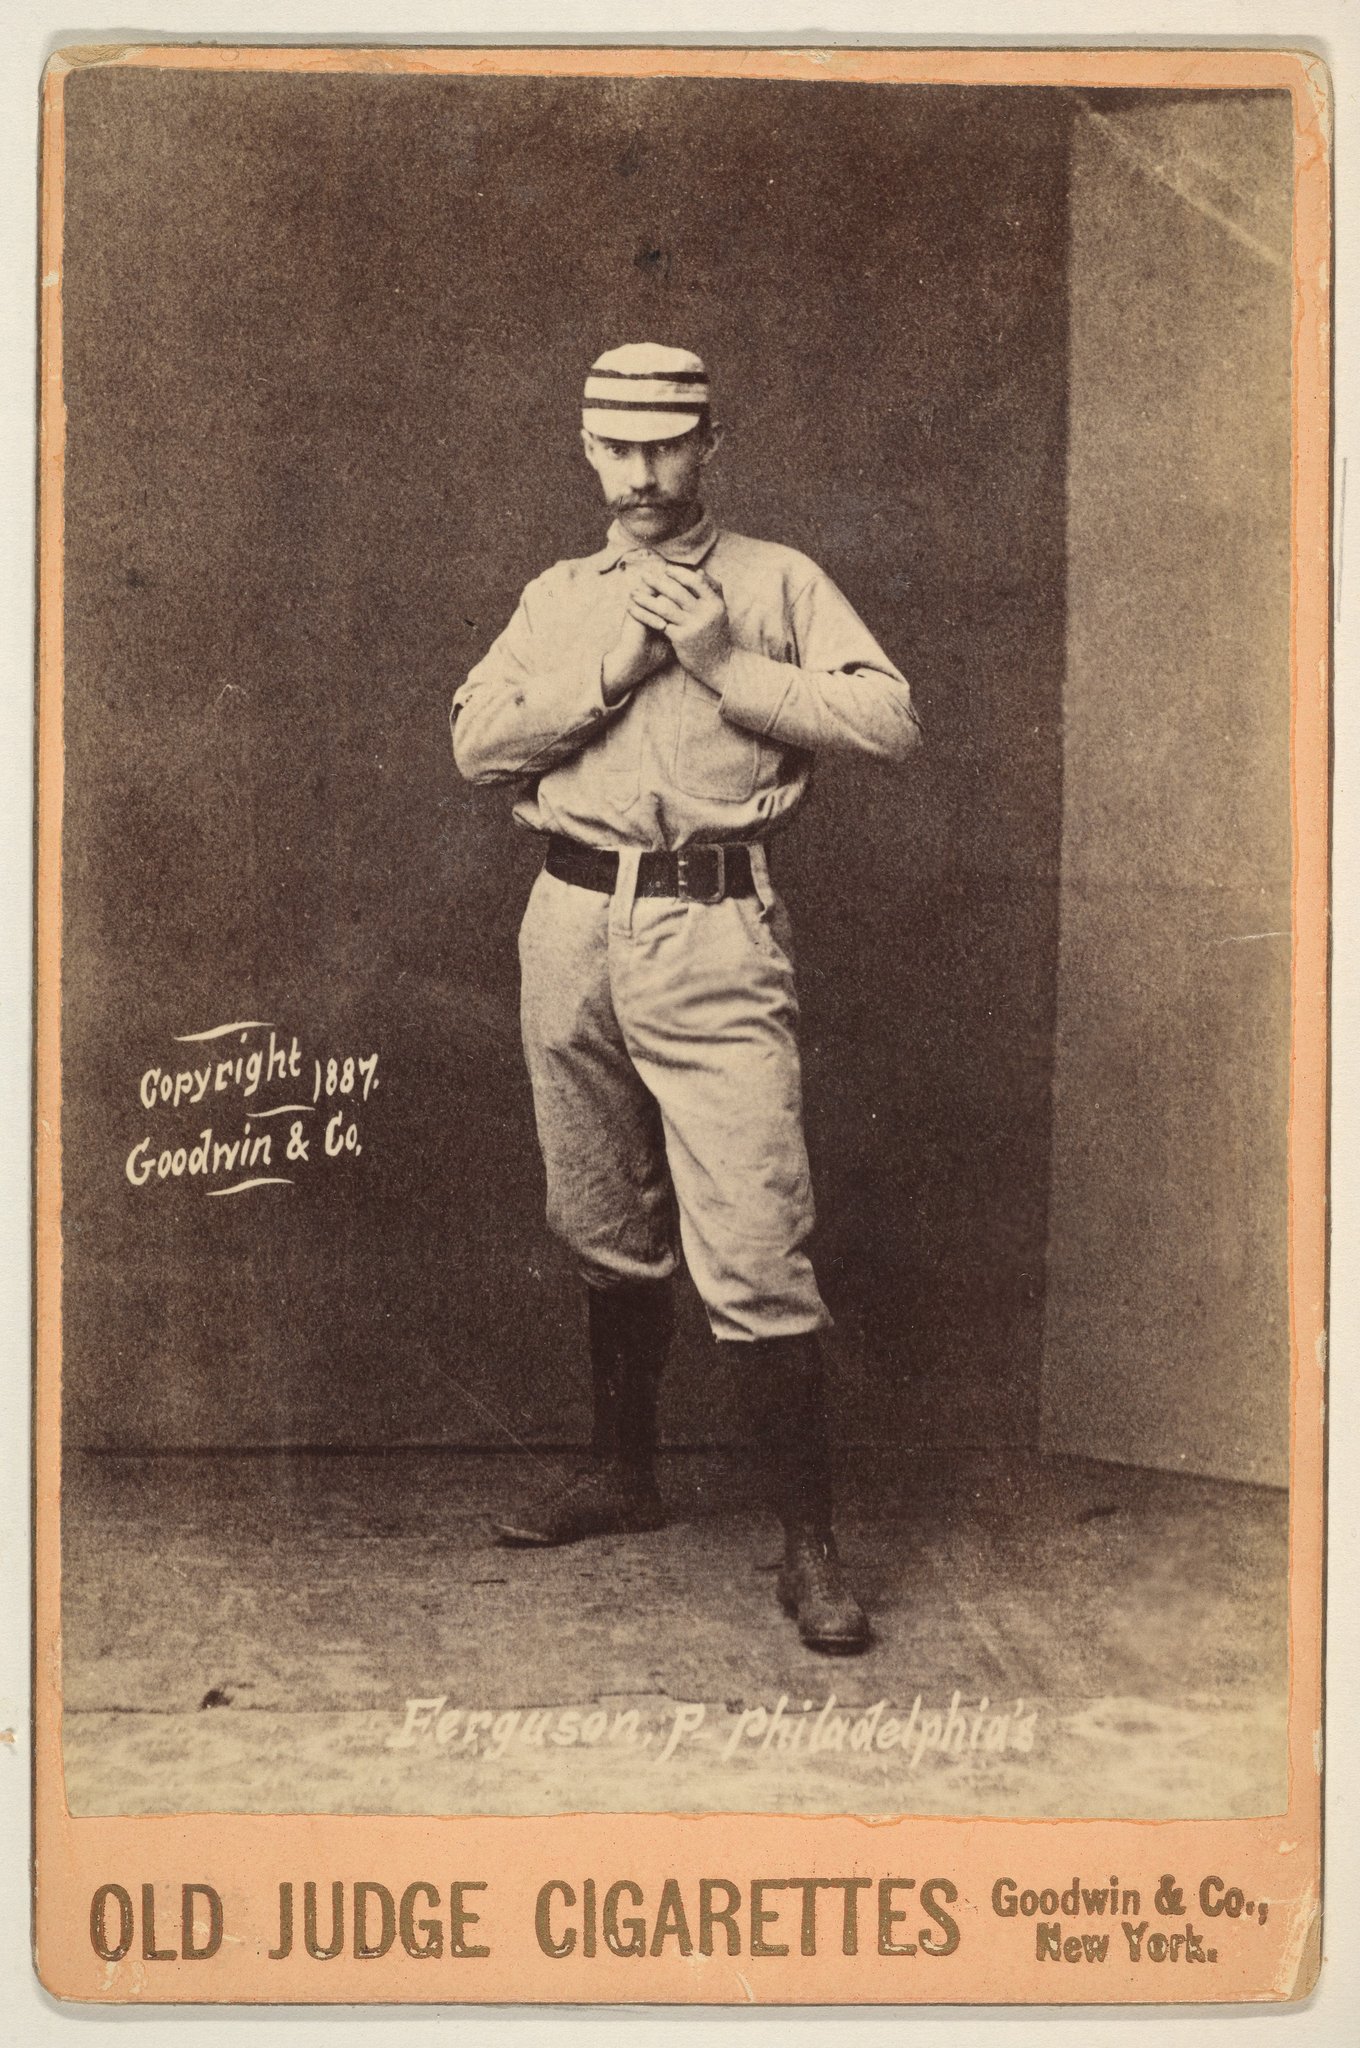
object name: baseball card, photograph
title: Ferguson, Pitcher, Philadelphia, from the series Old Judge Cigarettes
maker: goodwin & company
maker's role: publisher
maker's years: 1850-1950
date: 1887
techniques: albumen silver print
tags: men,portraits